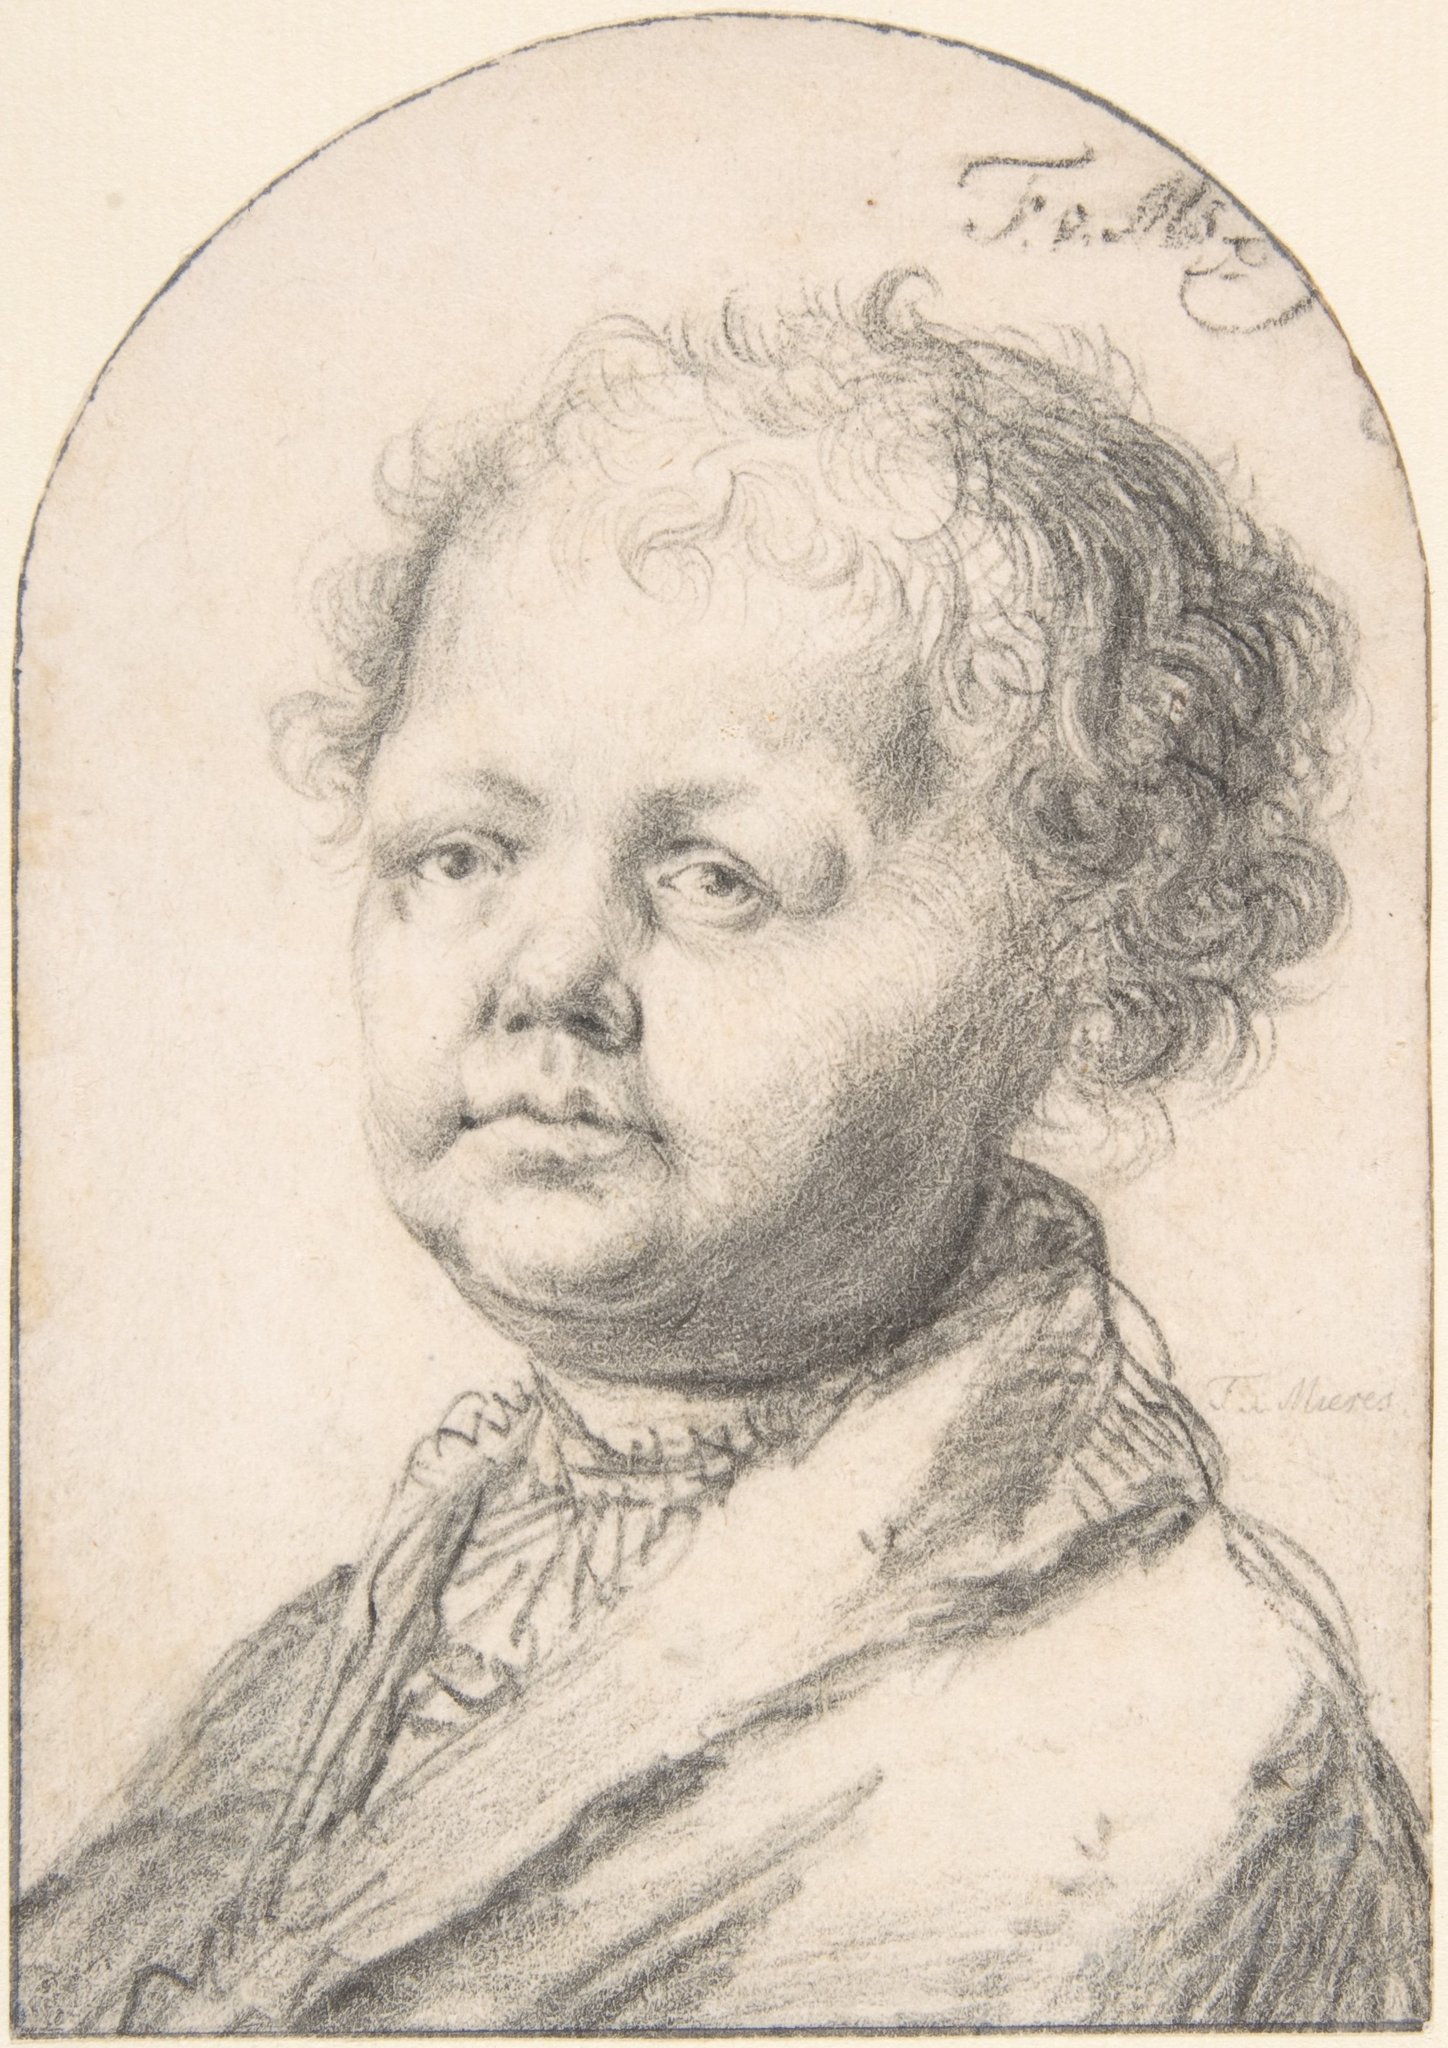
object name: drawing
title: Portrait of a Young Boy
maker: frans van mieris the elder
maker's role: artist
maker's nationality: dutch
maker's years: 1635-1681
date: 1601-1700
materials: chalk, graphite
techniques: heightening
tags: boys,portraits